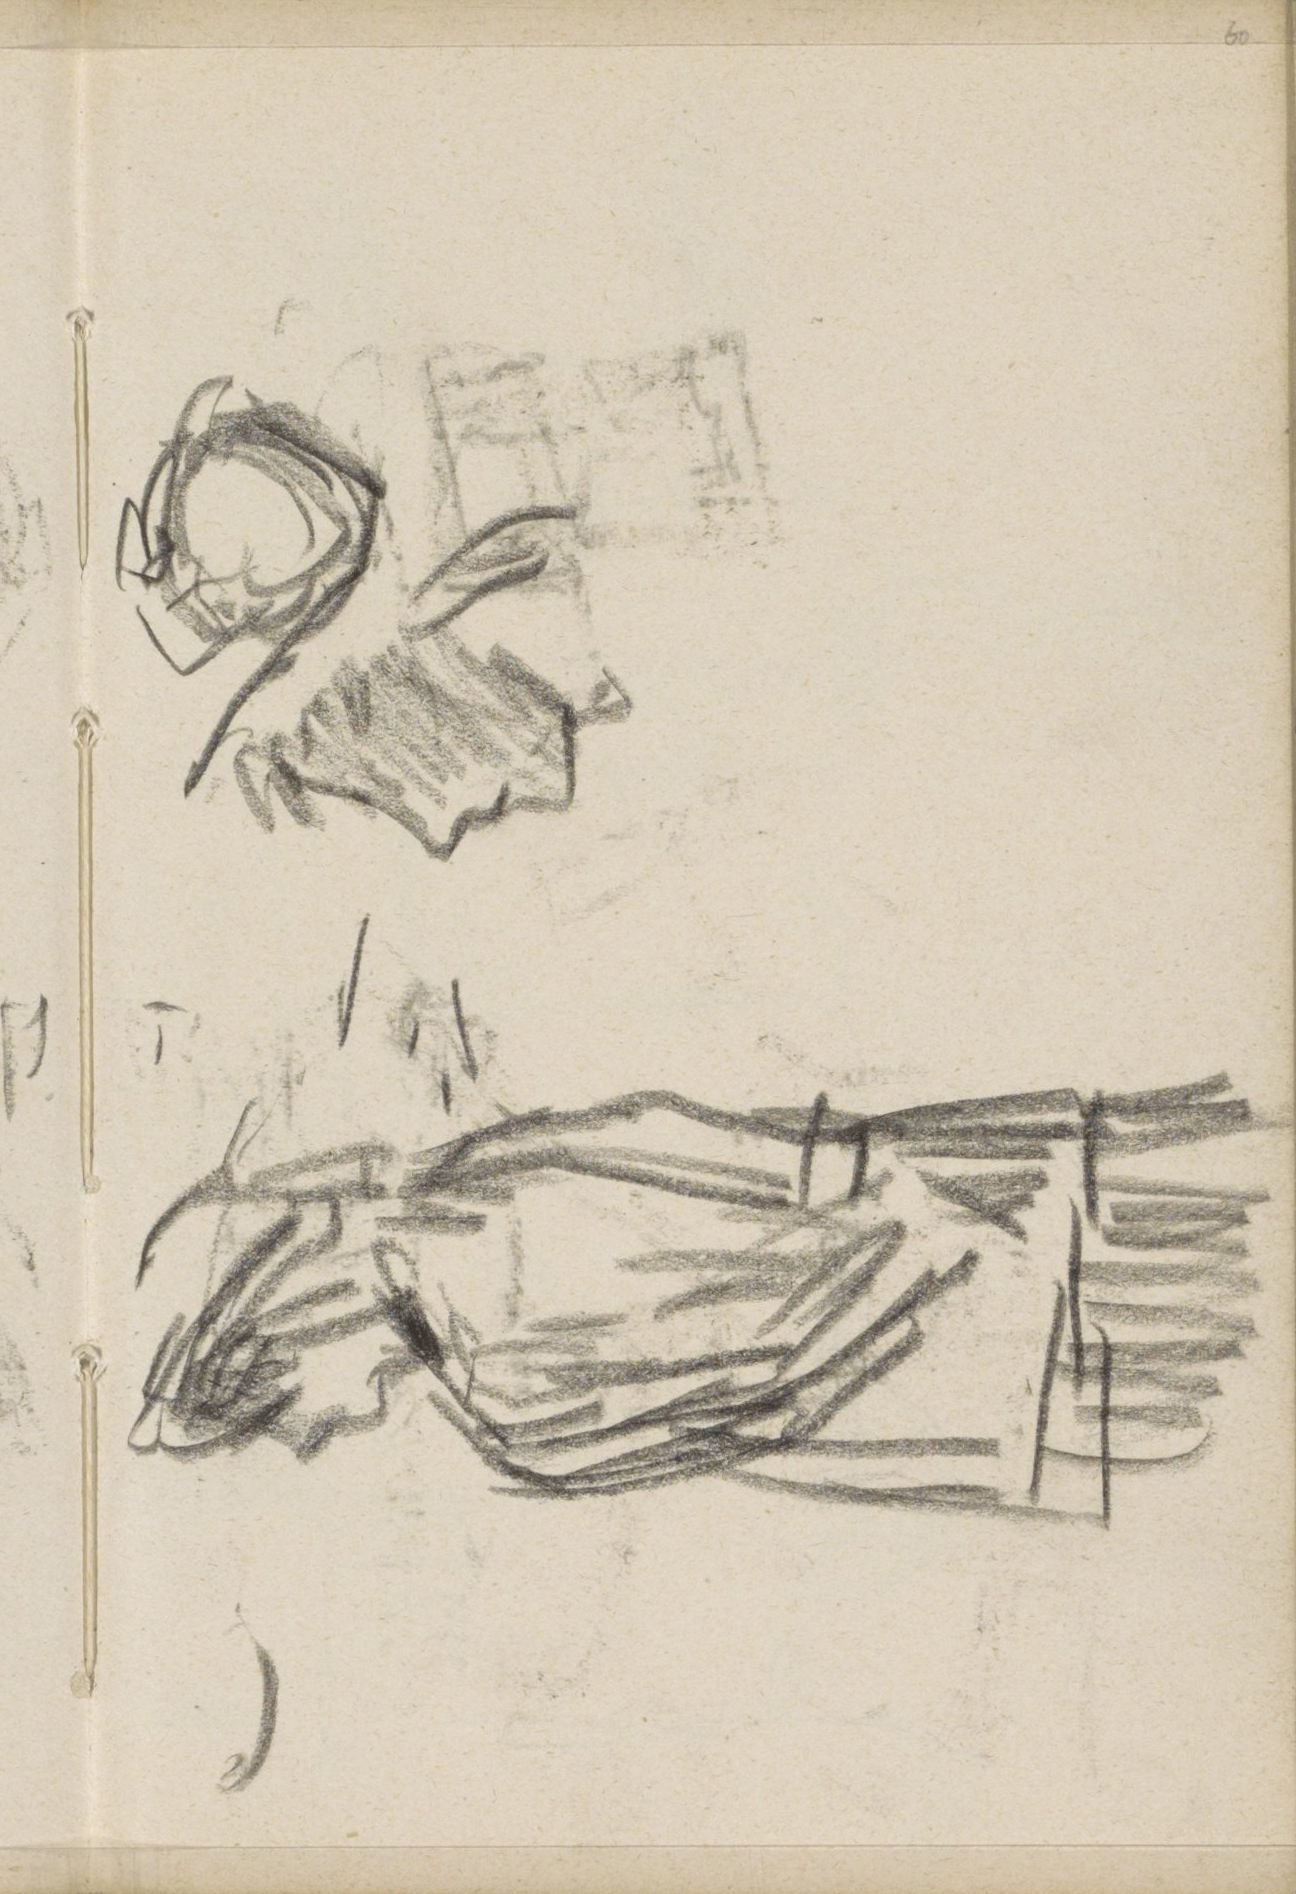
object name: sketchbook leaf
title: Studieblad met een staande vrouw en een vrouwenhoofd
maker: george hendrik breitner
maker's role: draughtsman, painter, print maker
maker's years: 1857-1923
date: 1907-1909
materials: chalk, paper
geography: amsterdam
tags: head-gear: hat (+ women's clothes), standing figure - aa - female human figure, head (human) - aa - female human figure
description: Studieblad met een staande vrouw en een vrouwenhoofd, in profiel naar links. Pagina 60 uit een schetsboek met 46 bladen vervaardigd te Antwerpen, Gent en Amsterdam.